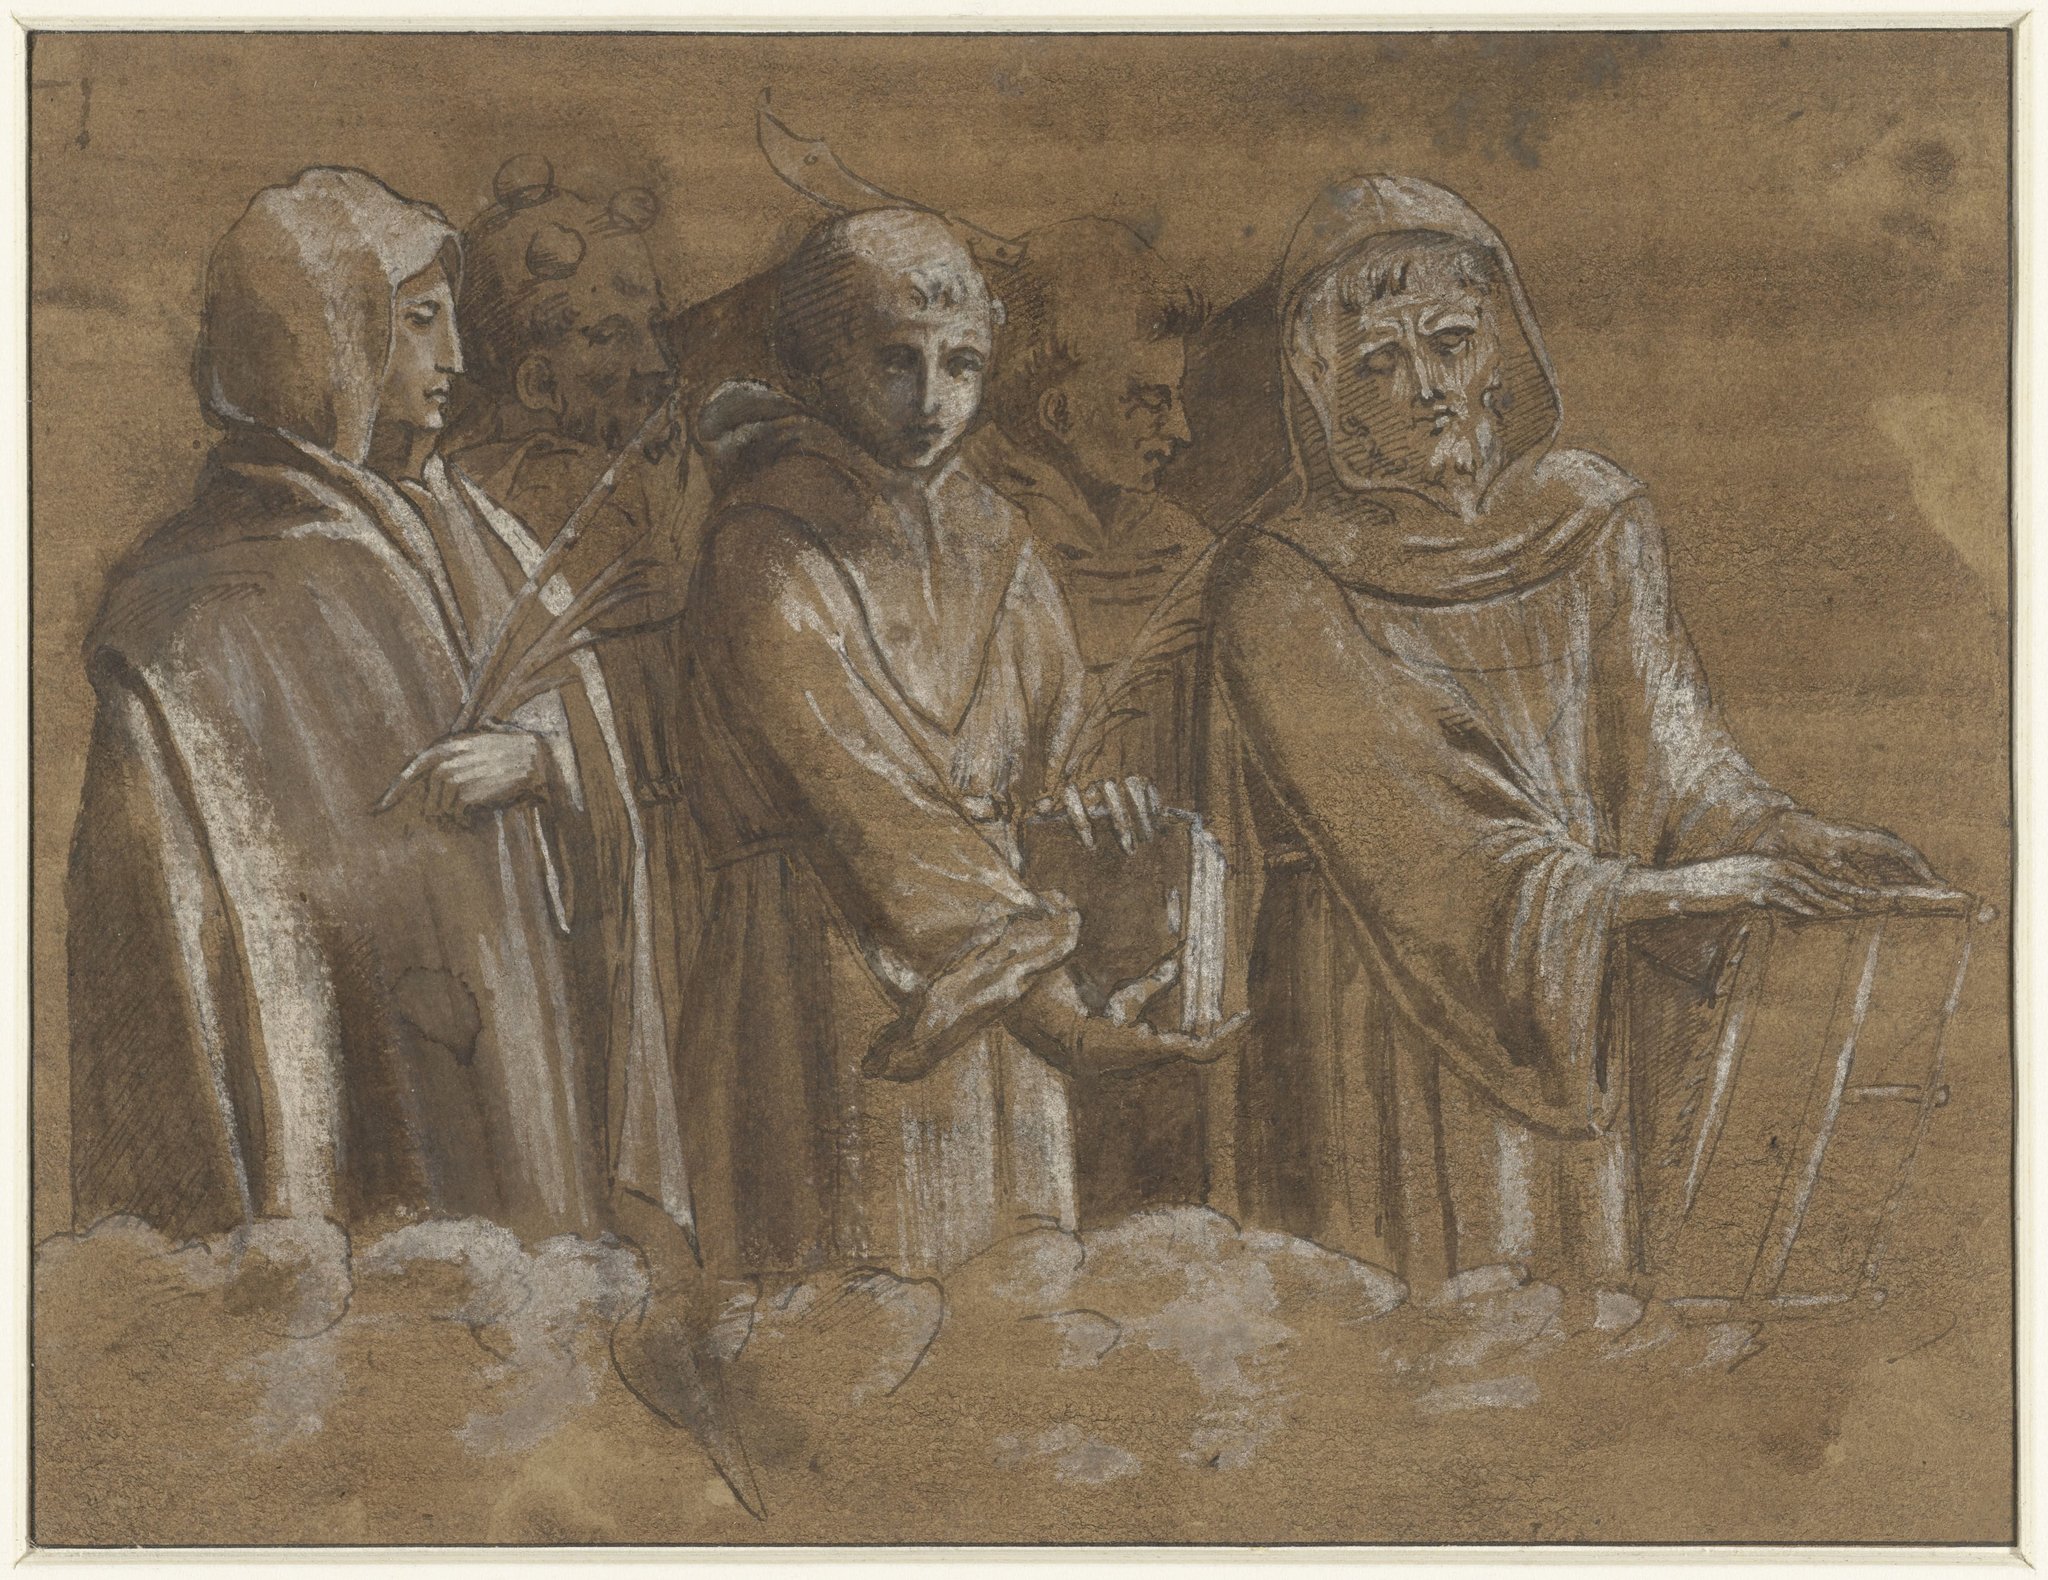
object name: drawing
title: Figuren van martelaars boven een wolkenrand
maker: Anonymous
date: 1500-1510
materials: ink, paper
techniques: brush, pen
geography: lombardy